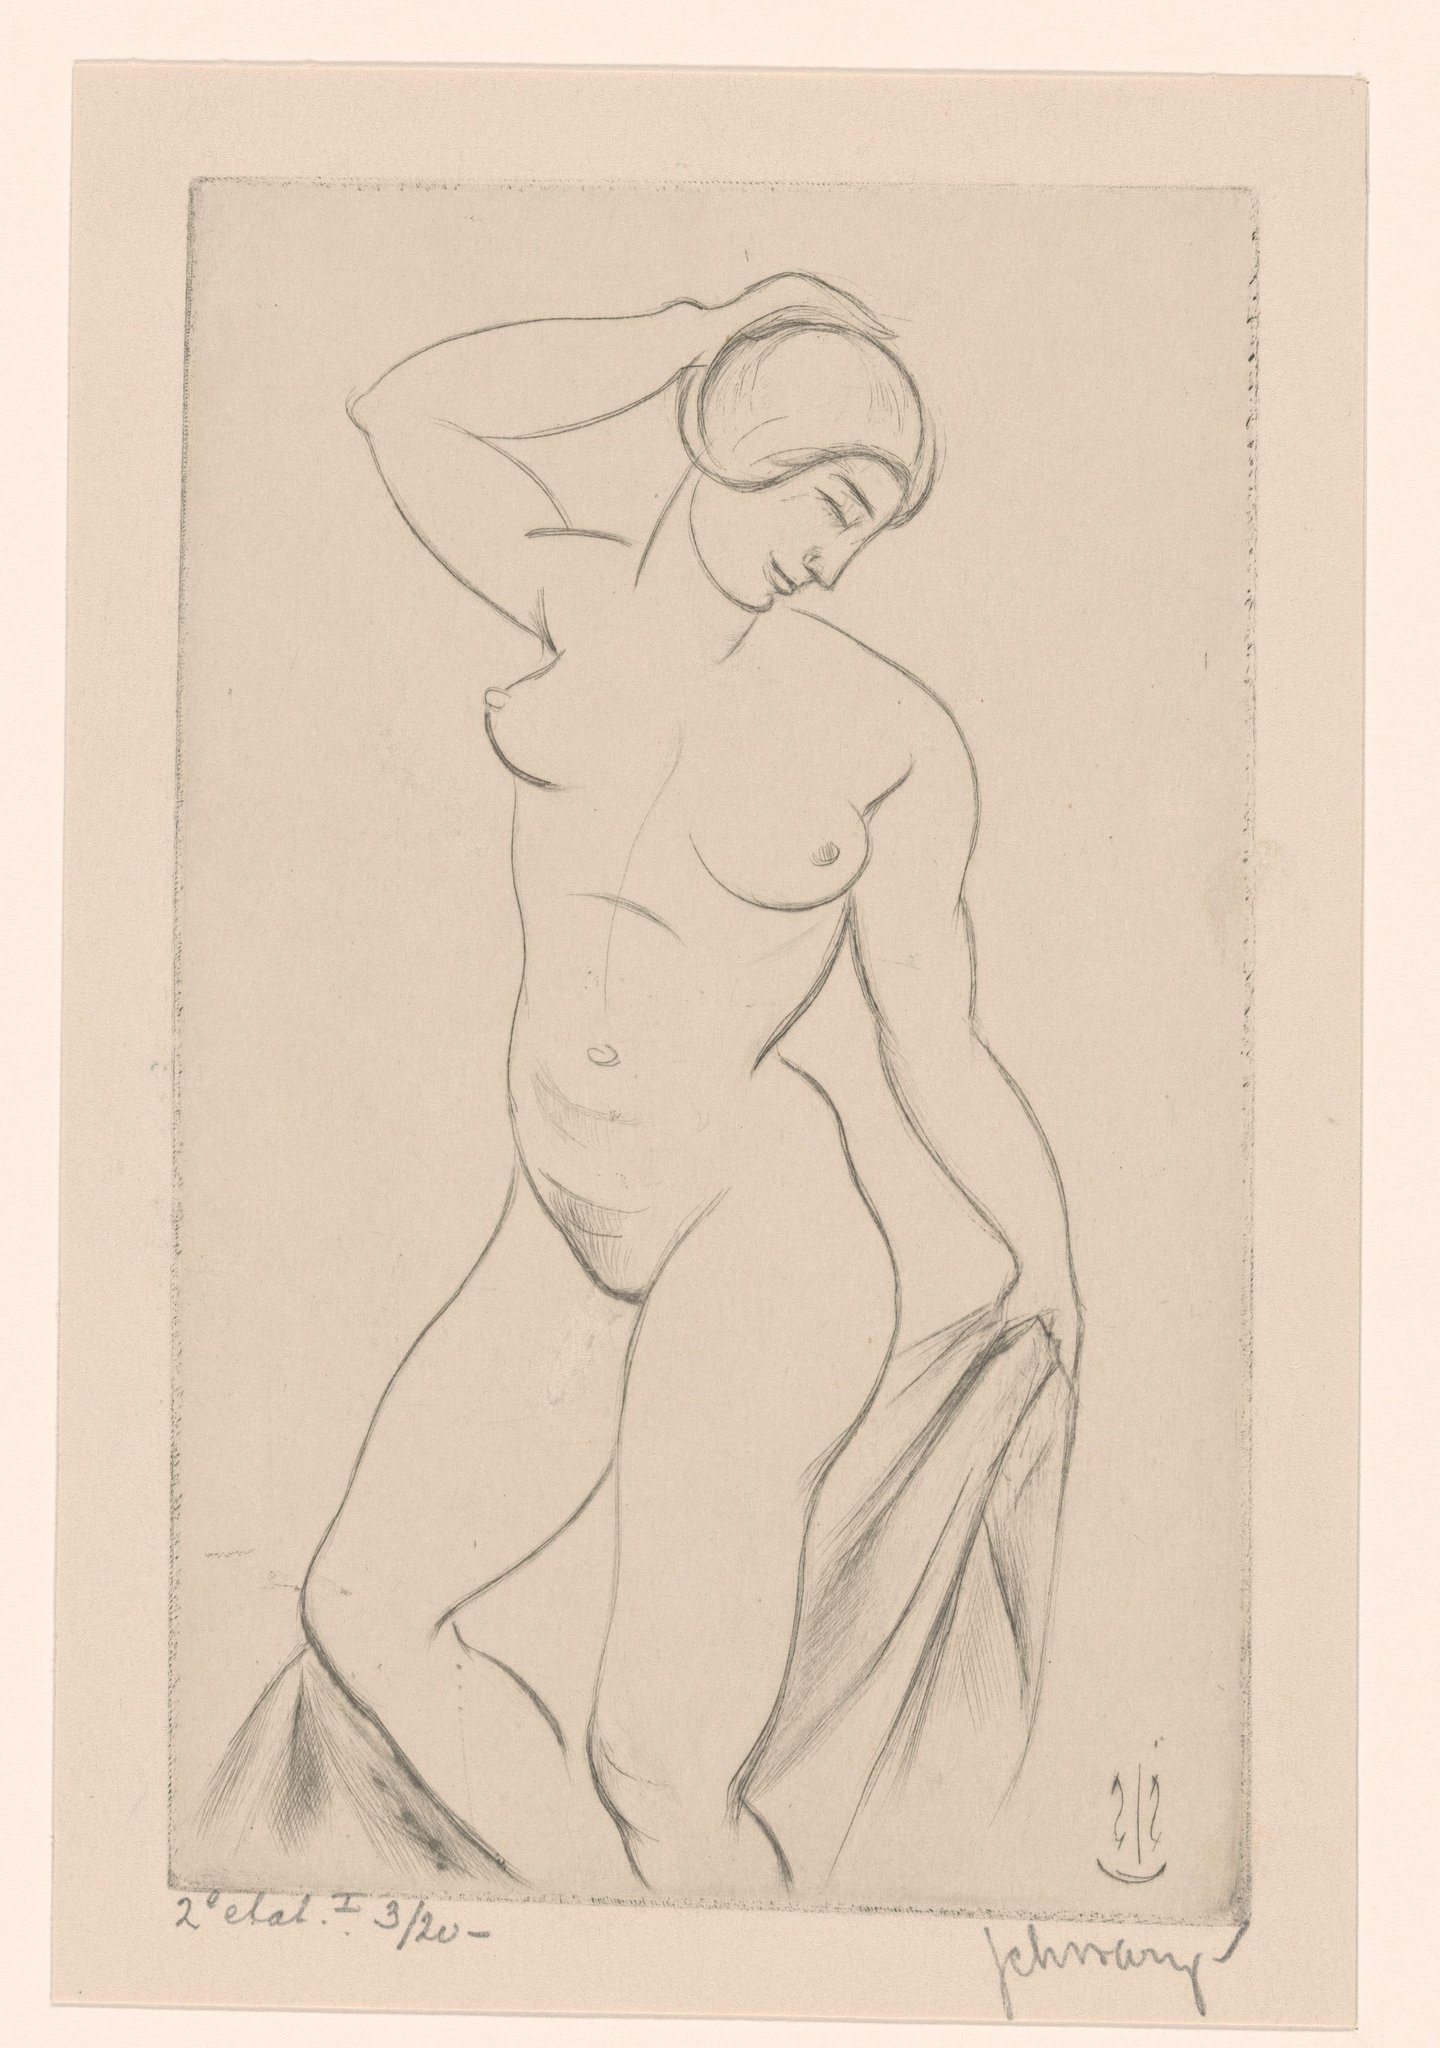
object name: print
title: Naakte vrouw met hand op het hoofd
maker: mommie schwarz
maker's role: print maker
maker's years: 1876-1942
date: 1886-1931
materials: paper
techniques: drypoint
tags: woman (showing herself) undressed, quasi-nude, hand(s) bent towards the head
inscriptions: collector's mark: Lugt 2228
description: Een staande naakte vrouw legt haar rechterhand op haar hoofd. Met haar linkerhand houdt ze een doek vast.